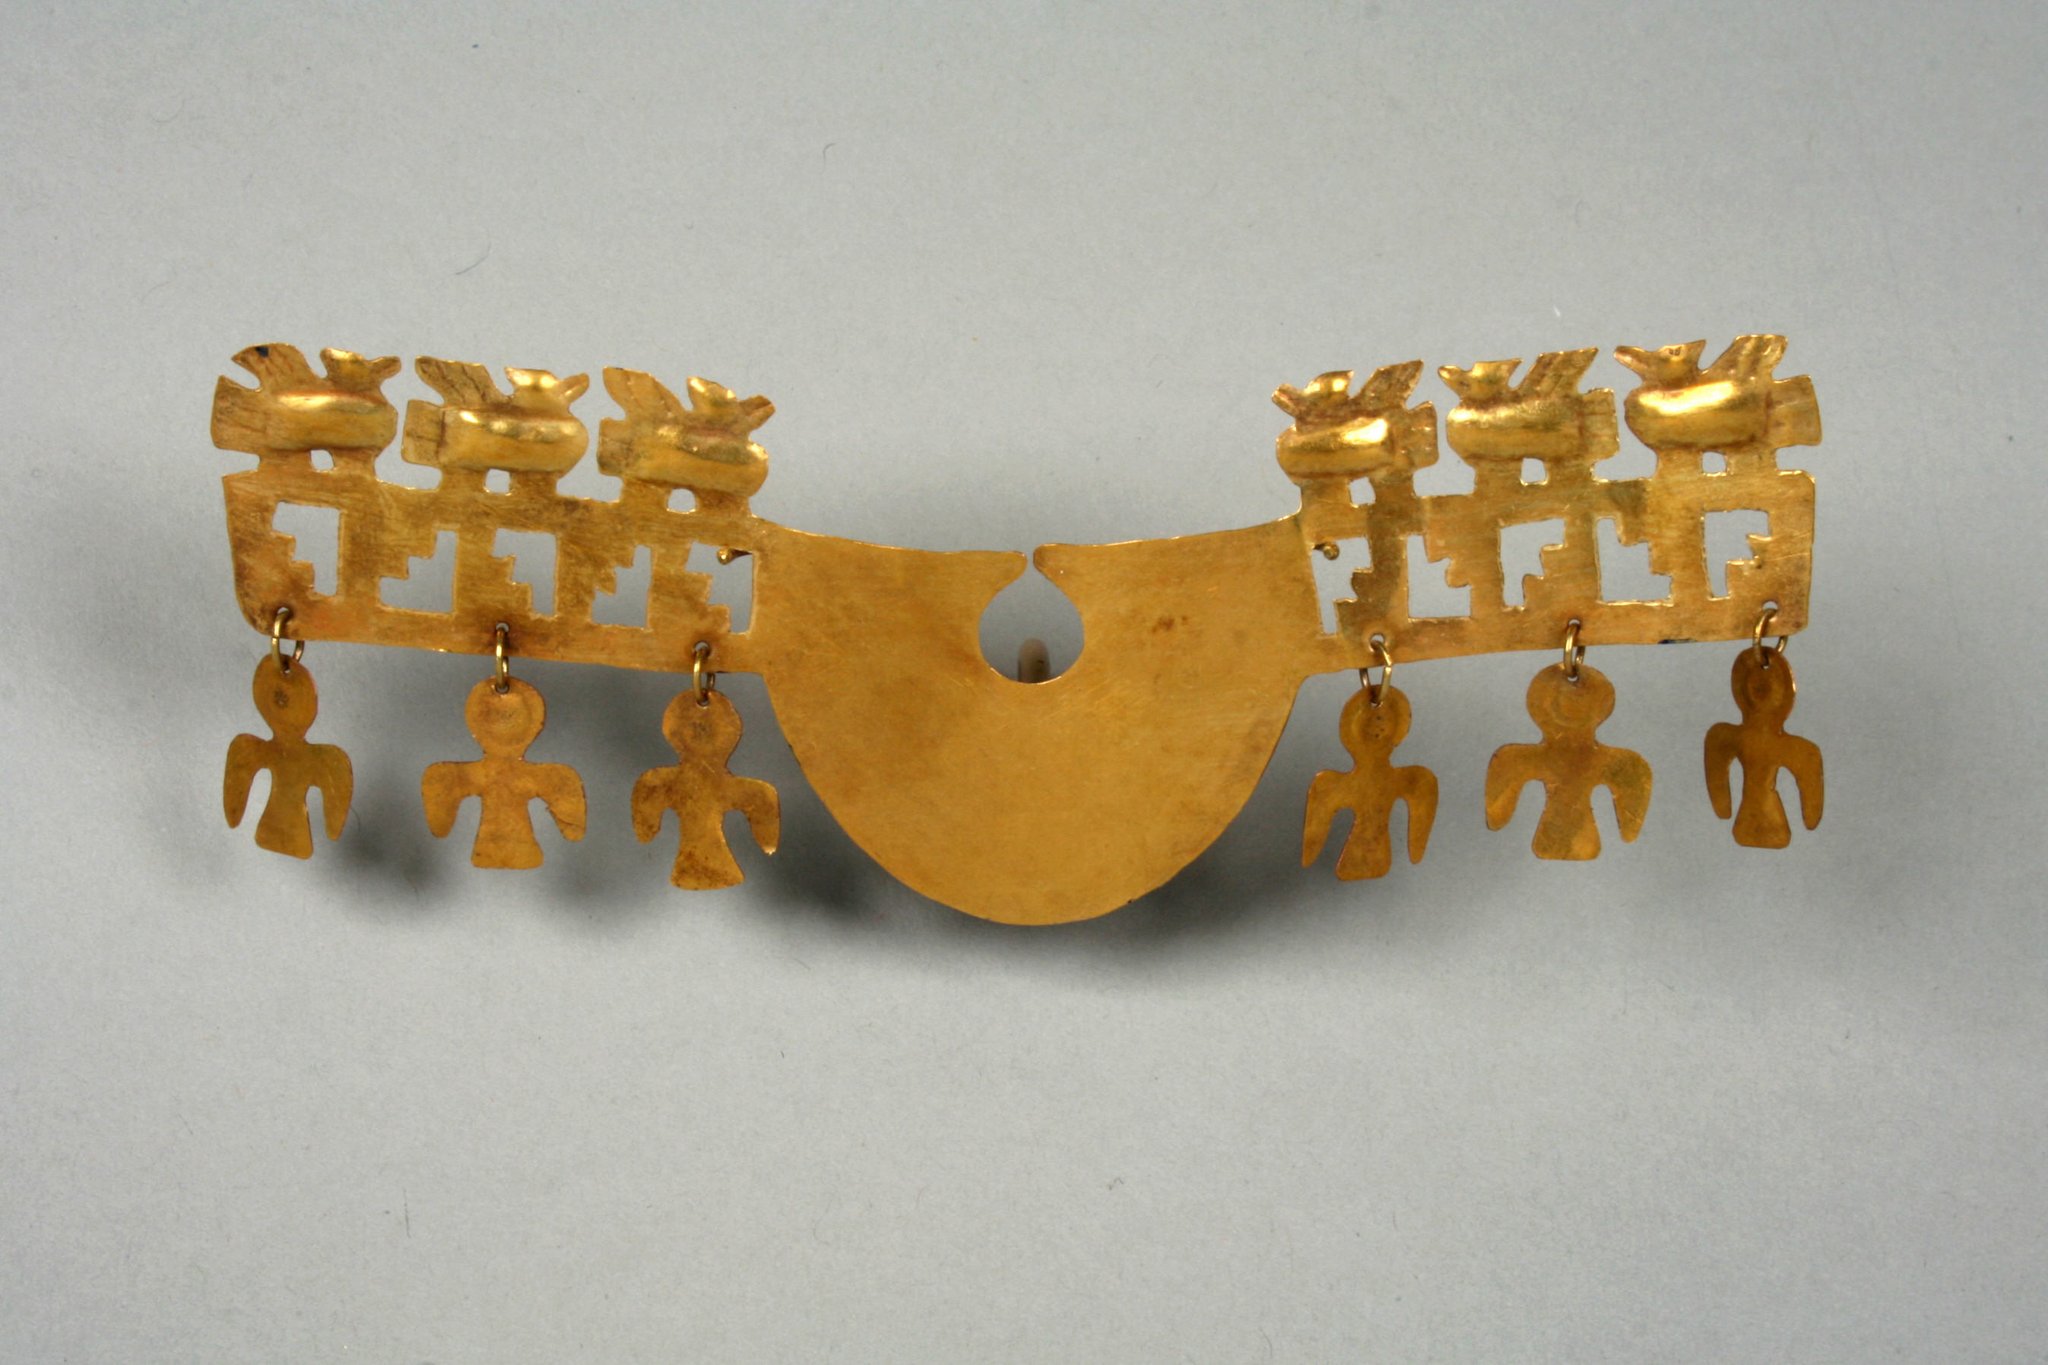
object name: nose ornament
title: Nose Ornament with Birds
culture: ecuador or peru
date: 200 BCE-200 CE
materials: gold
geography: peru or ecuador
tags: birds